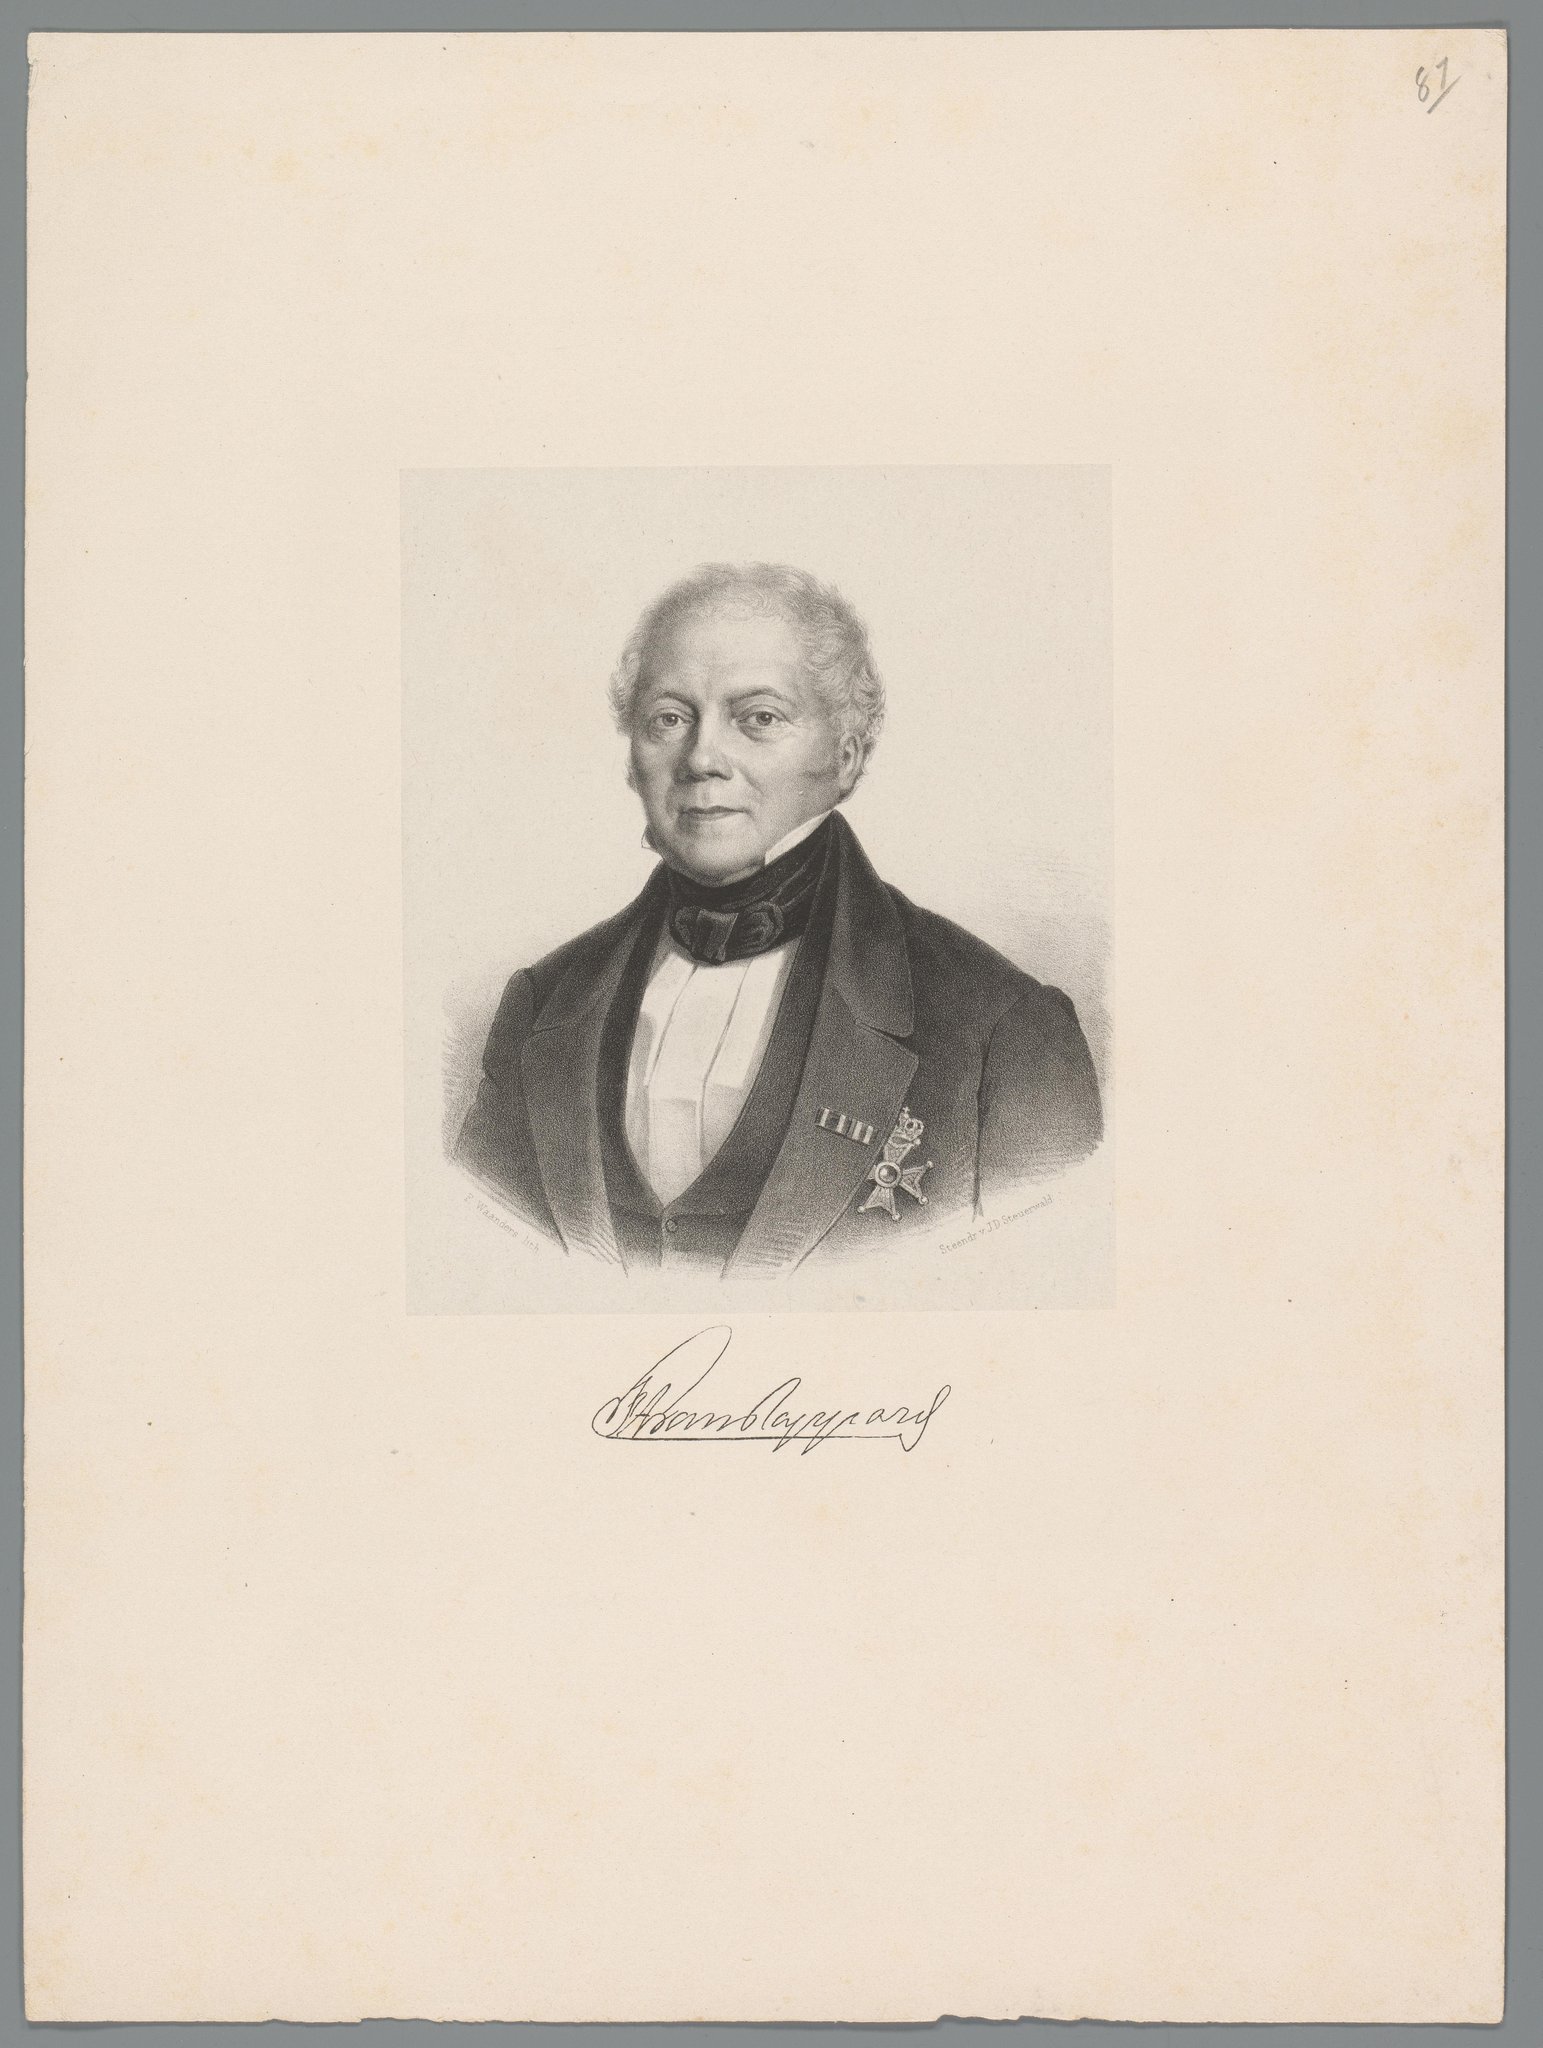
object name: print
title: Portret van Frans Alexander van Rappard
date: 1833-1863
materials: paper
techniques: lithograph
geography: the hague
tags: utrecht, knighthood order, historical persons